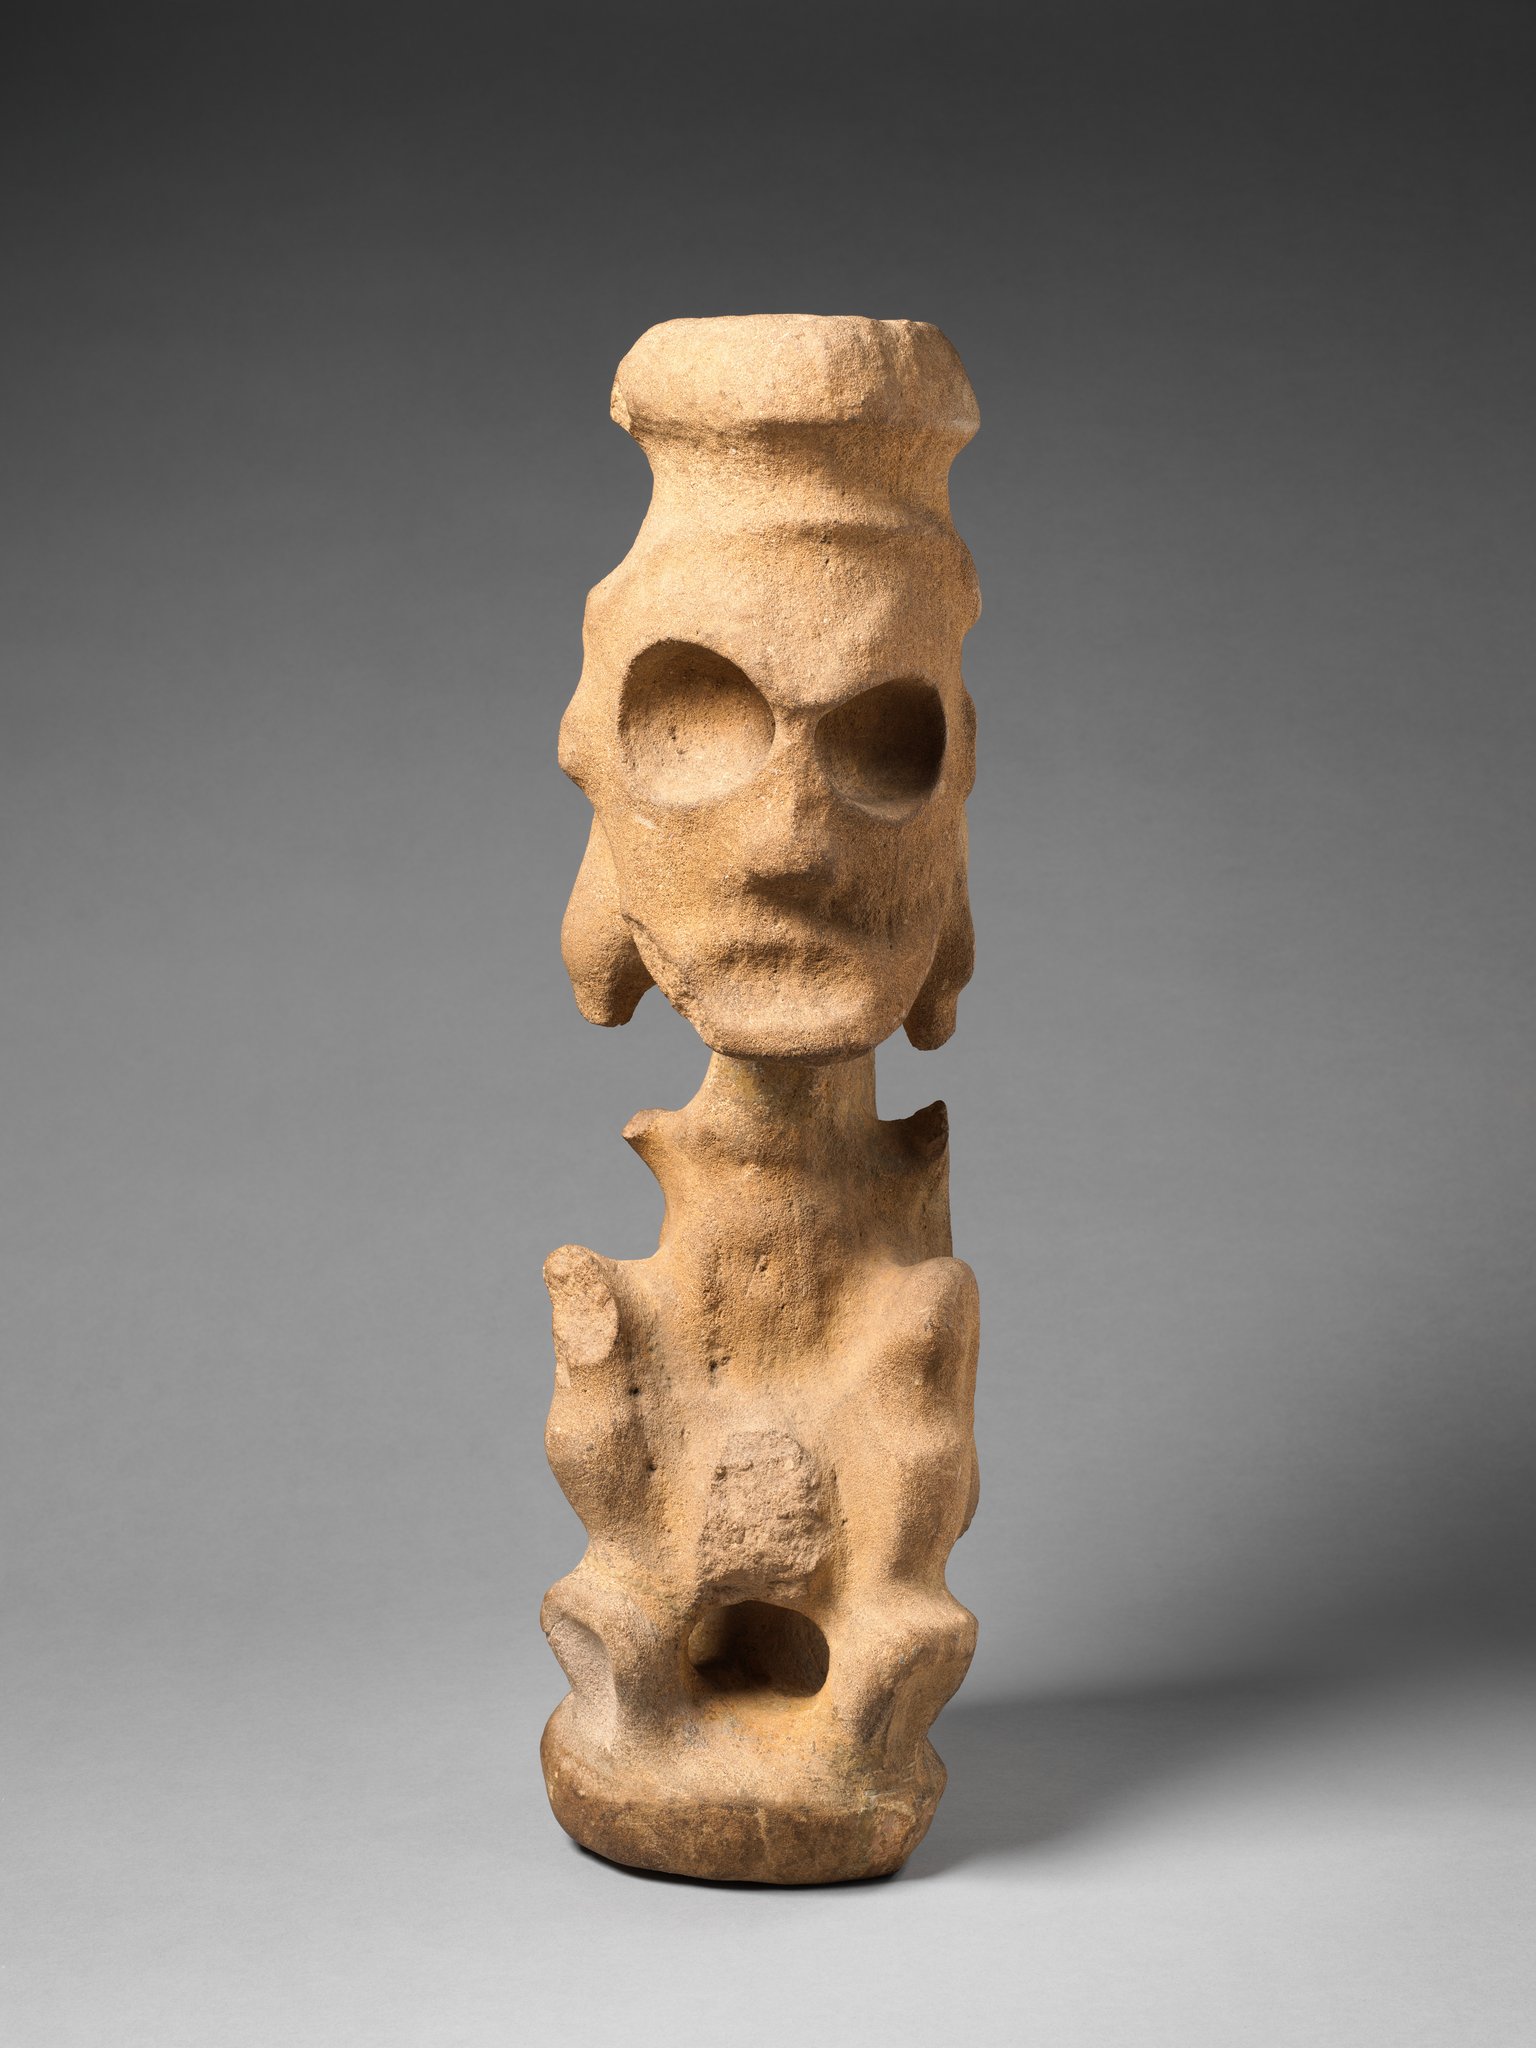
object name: figure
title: Zemí figure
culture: taíno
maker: taíno artist(s)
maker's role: artist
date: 1200-1500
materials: stone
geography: dominican republic